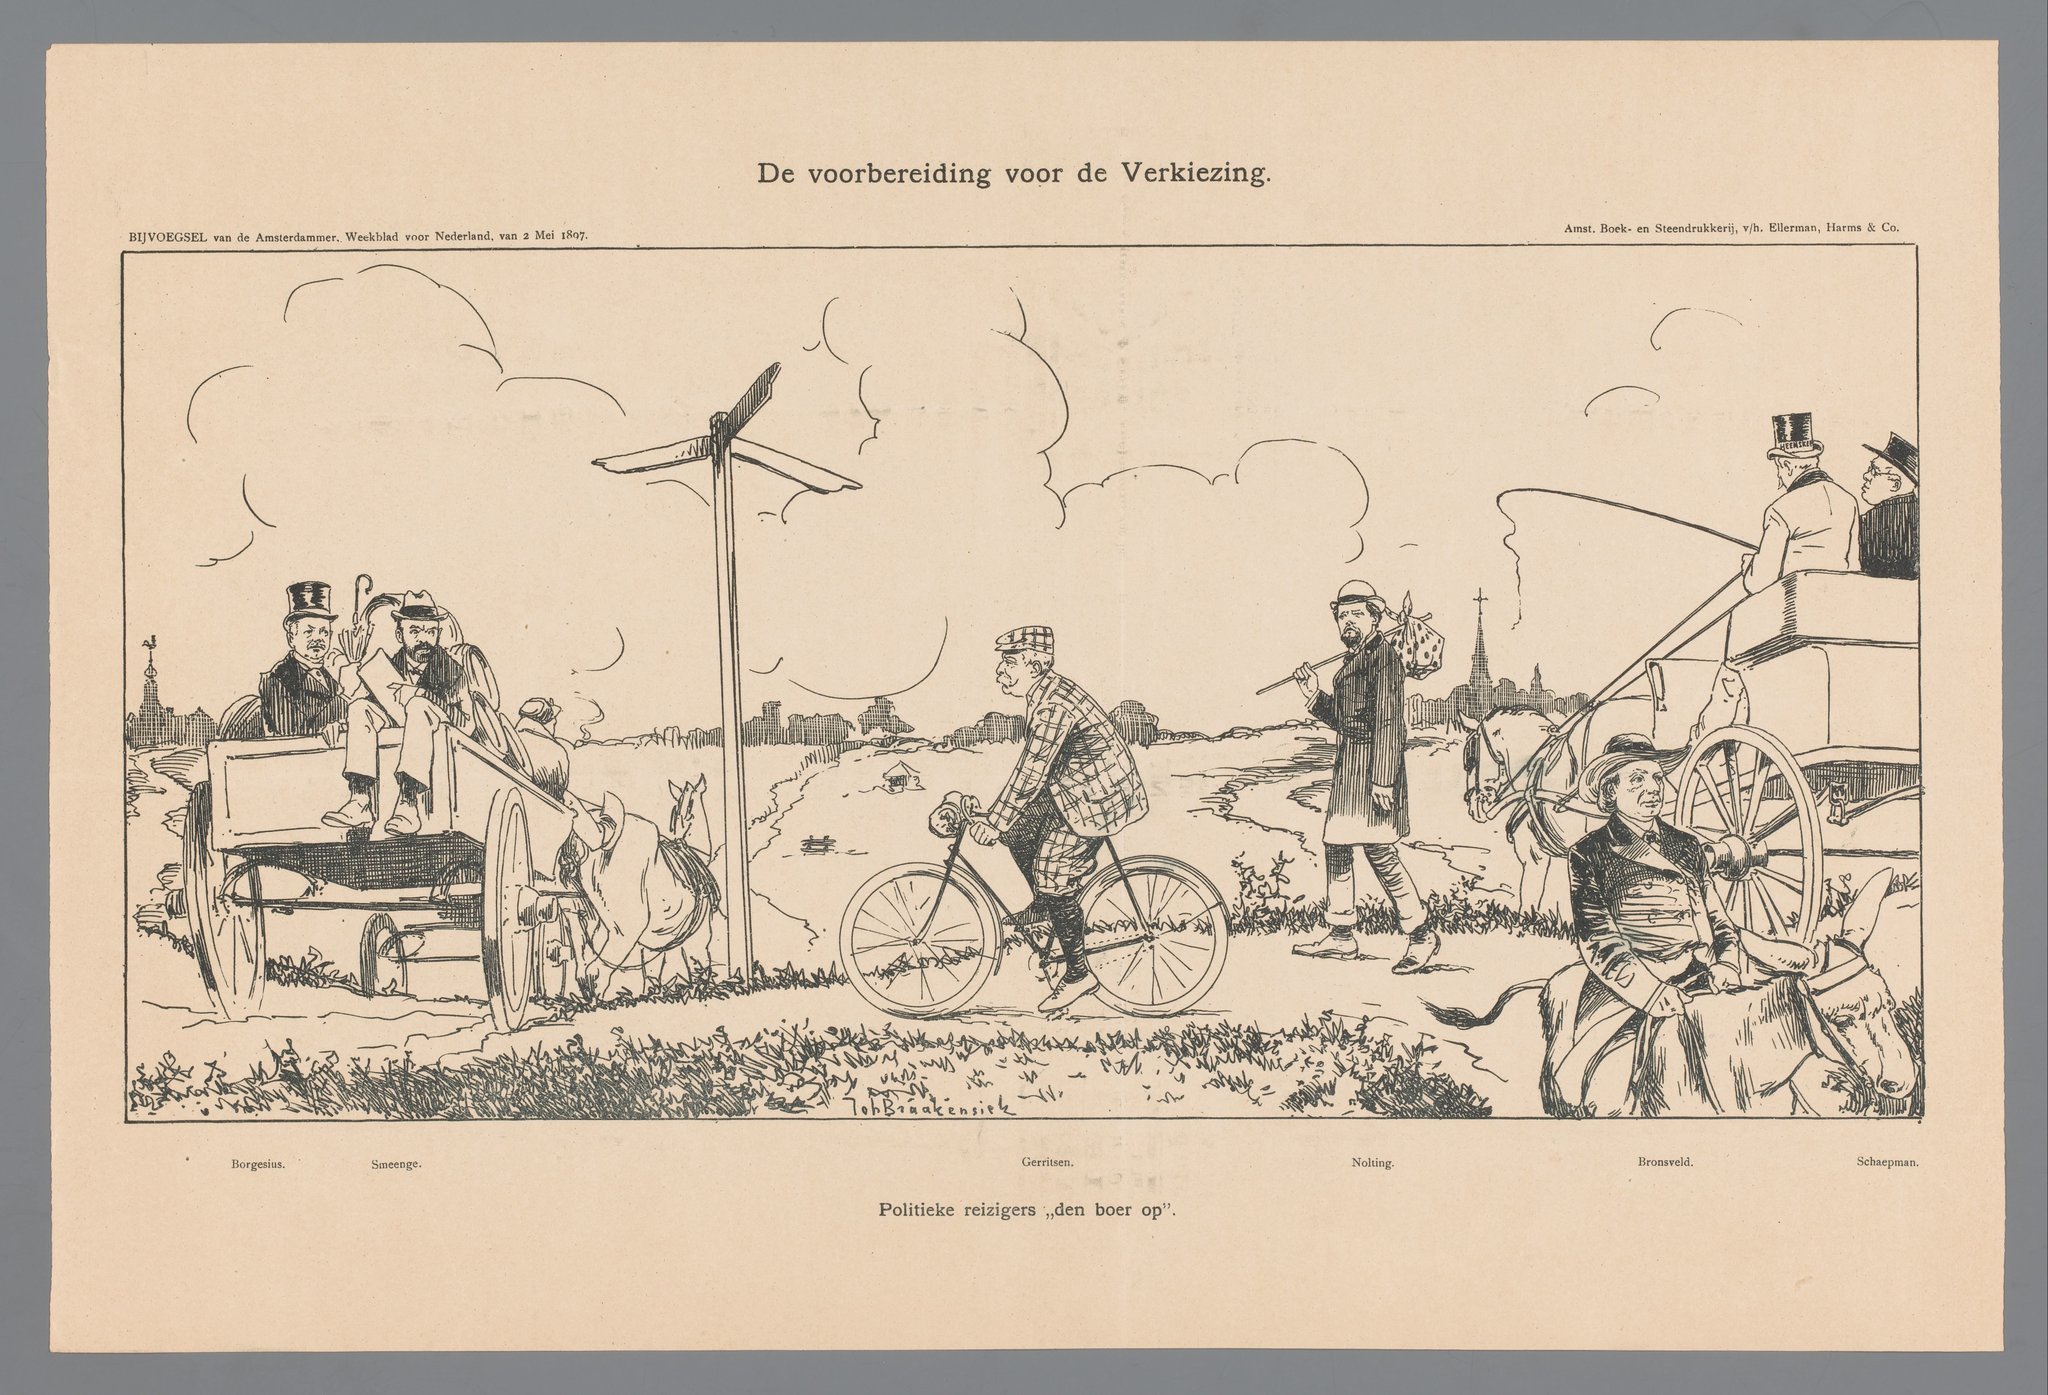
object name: cartoon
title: De voorbereiding voor de Verkiezing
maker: johan braakensiek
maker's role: draughtsman, print maker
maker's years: 1858-1940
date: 1897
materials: paper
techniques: lithograph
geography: amsterdam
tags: amsterdam, politician, rome, priest, herman johannes aloysius maria schaepman, utrecht, riding a horse, ass, or mule; rider, horseman, four-wheeled vehicle drawn by one animal, voting, election, historical persons, politician, e.g. party leader, knapsack, rucksack, bicycle, outskirts of city, political caricatures and satires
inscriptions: date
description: Prent uit het bijvoegsel van: De Amsterdammer. Weekblad voor Nederland, 2 mei 1897.